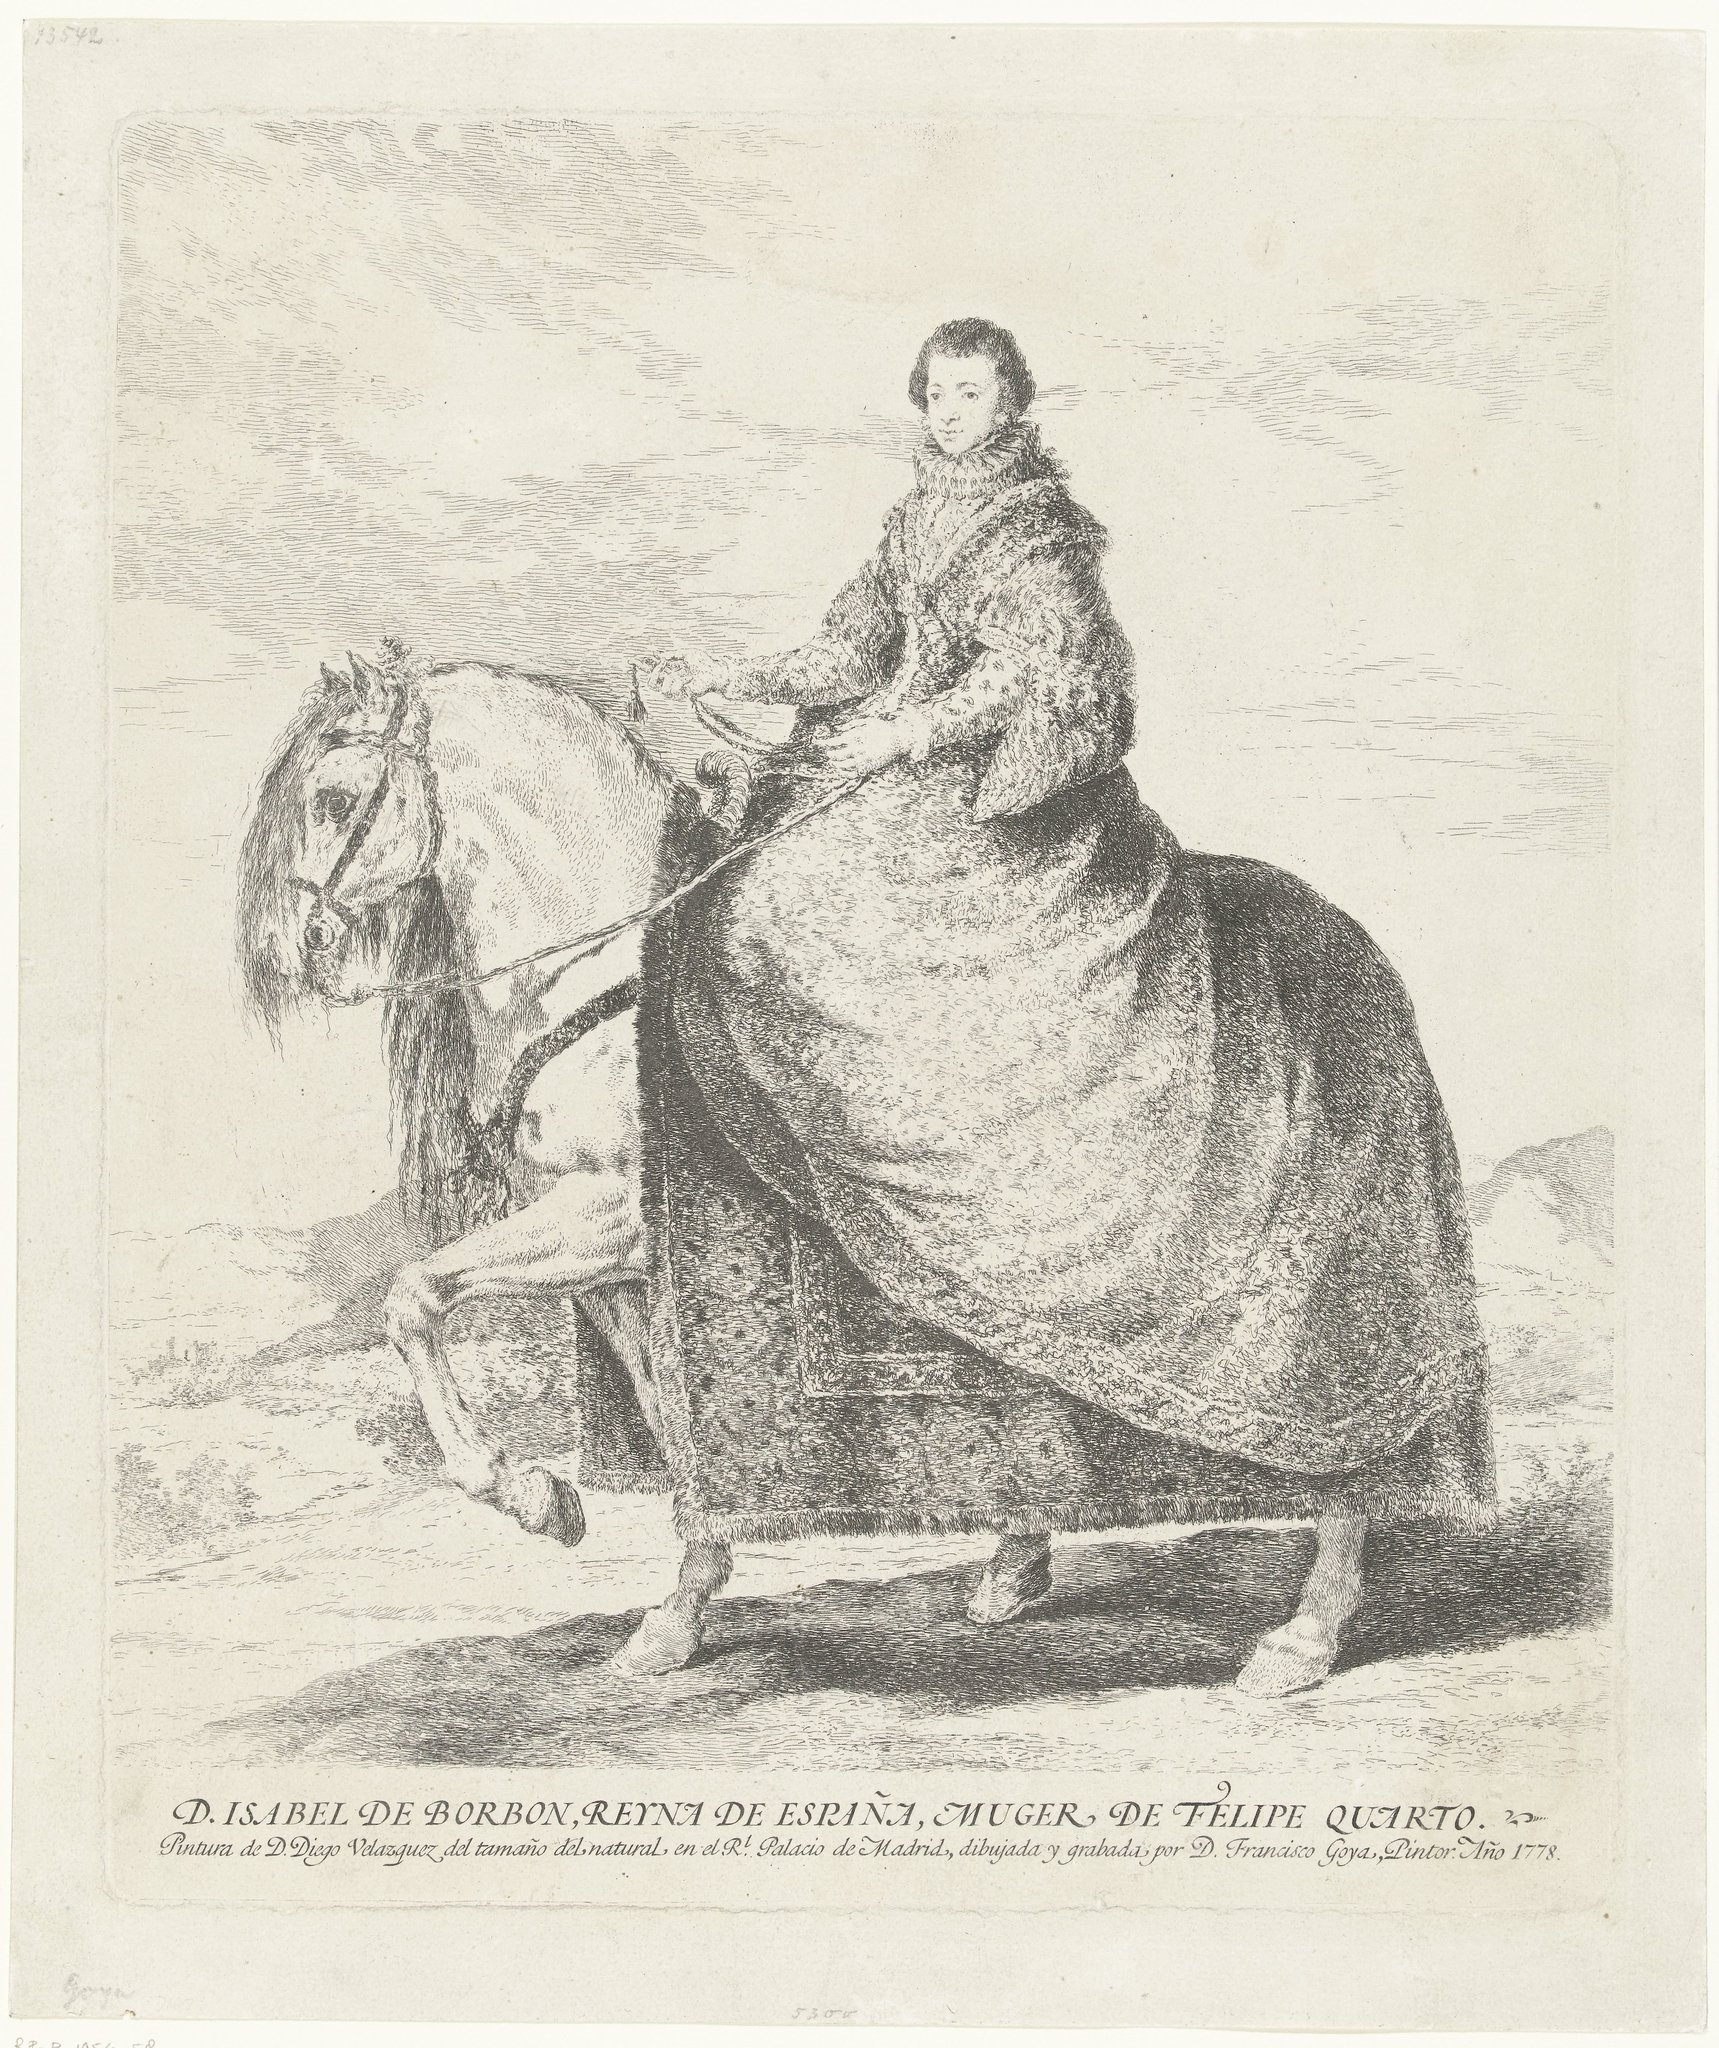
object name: print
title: D. Isabel de Borbon, Reyna de España, muger de Felipe Quatro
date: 1778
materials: paper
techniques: drypoint, etching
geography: madrid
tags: elisabeth of france (queen of spain and portugal), equestrian state-portrait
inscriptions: collector's mark: Lugt 2228, collector's mark:, collector's mark: Lugt 2760, collector's mark: Lugt 2237a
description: Ruiterportret van Isabella van Bourbon, eerste echtgenote van Koning Filips IV van Spanje.